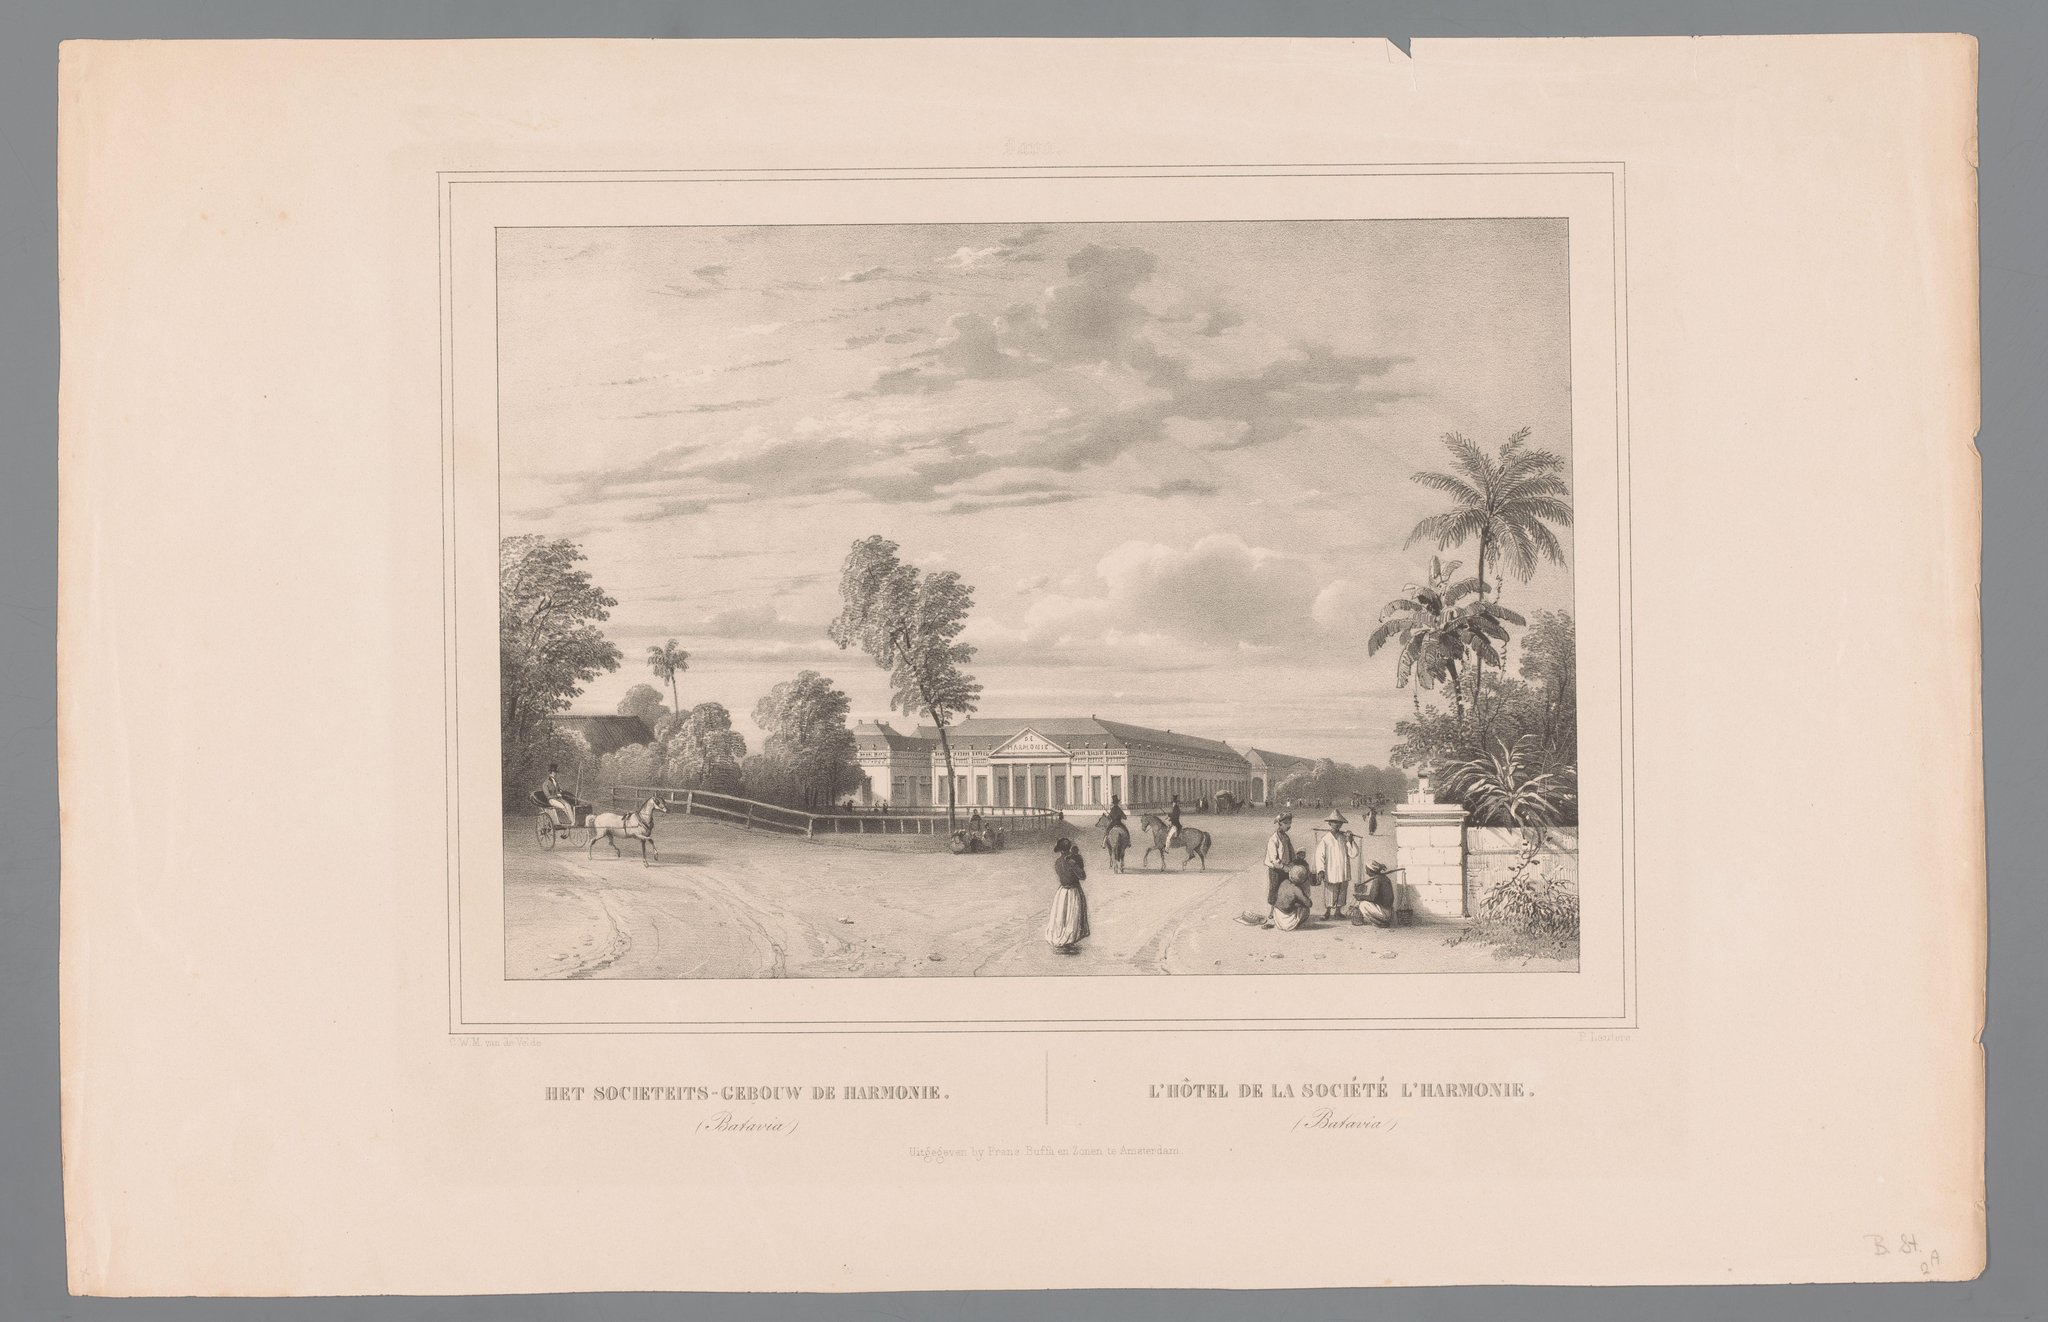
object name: print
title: Java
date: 1847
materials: paper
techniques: lithograph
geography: amsterdam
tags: civic architecture; edifices; dwellings, city-view in general; 'veduta' (+ city(-scape) with figures, staffage), batavia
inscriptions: collector's mark: Lugt 2228